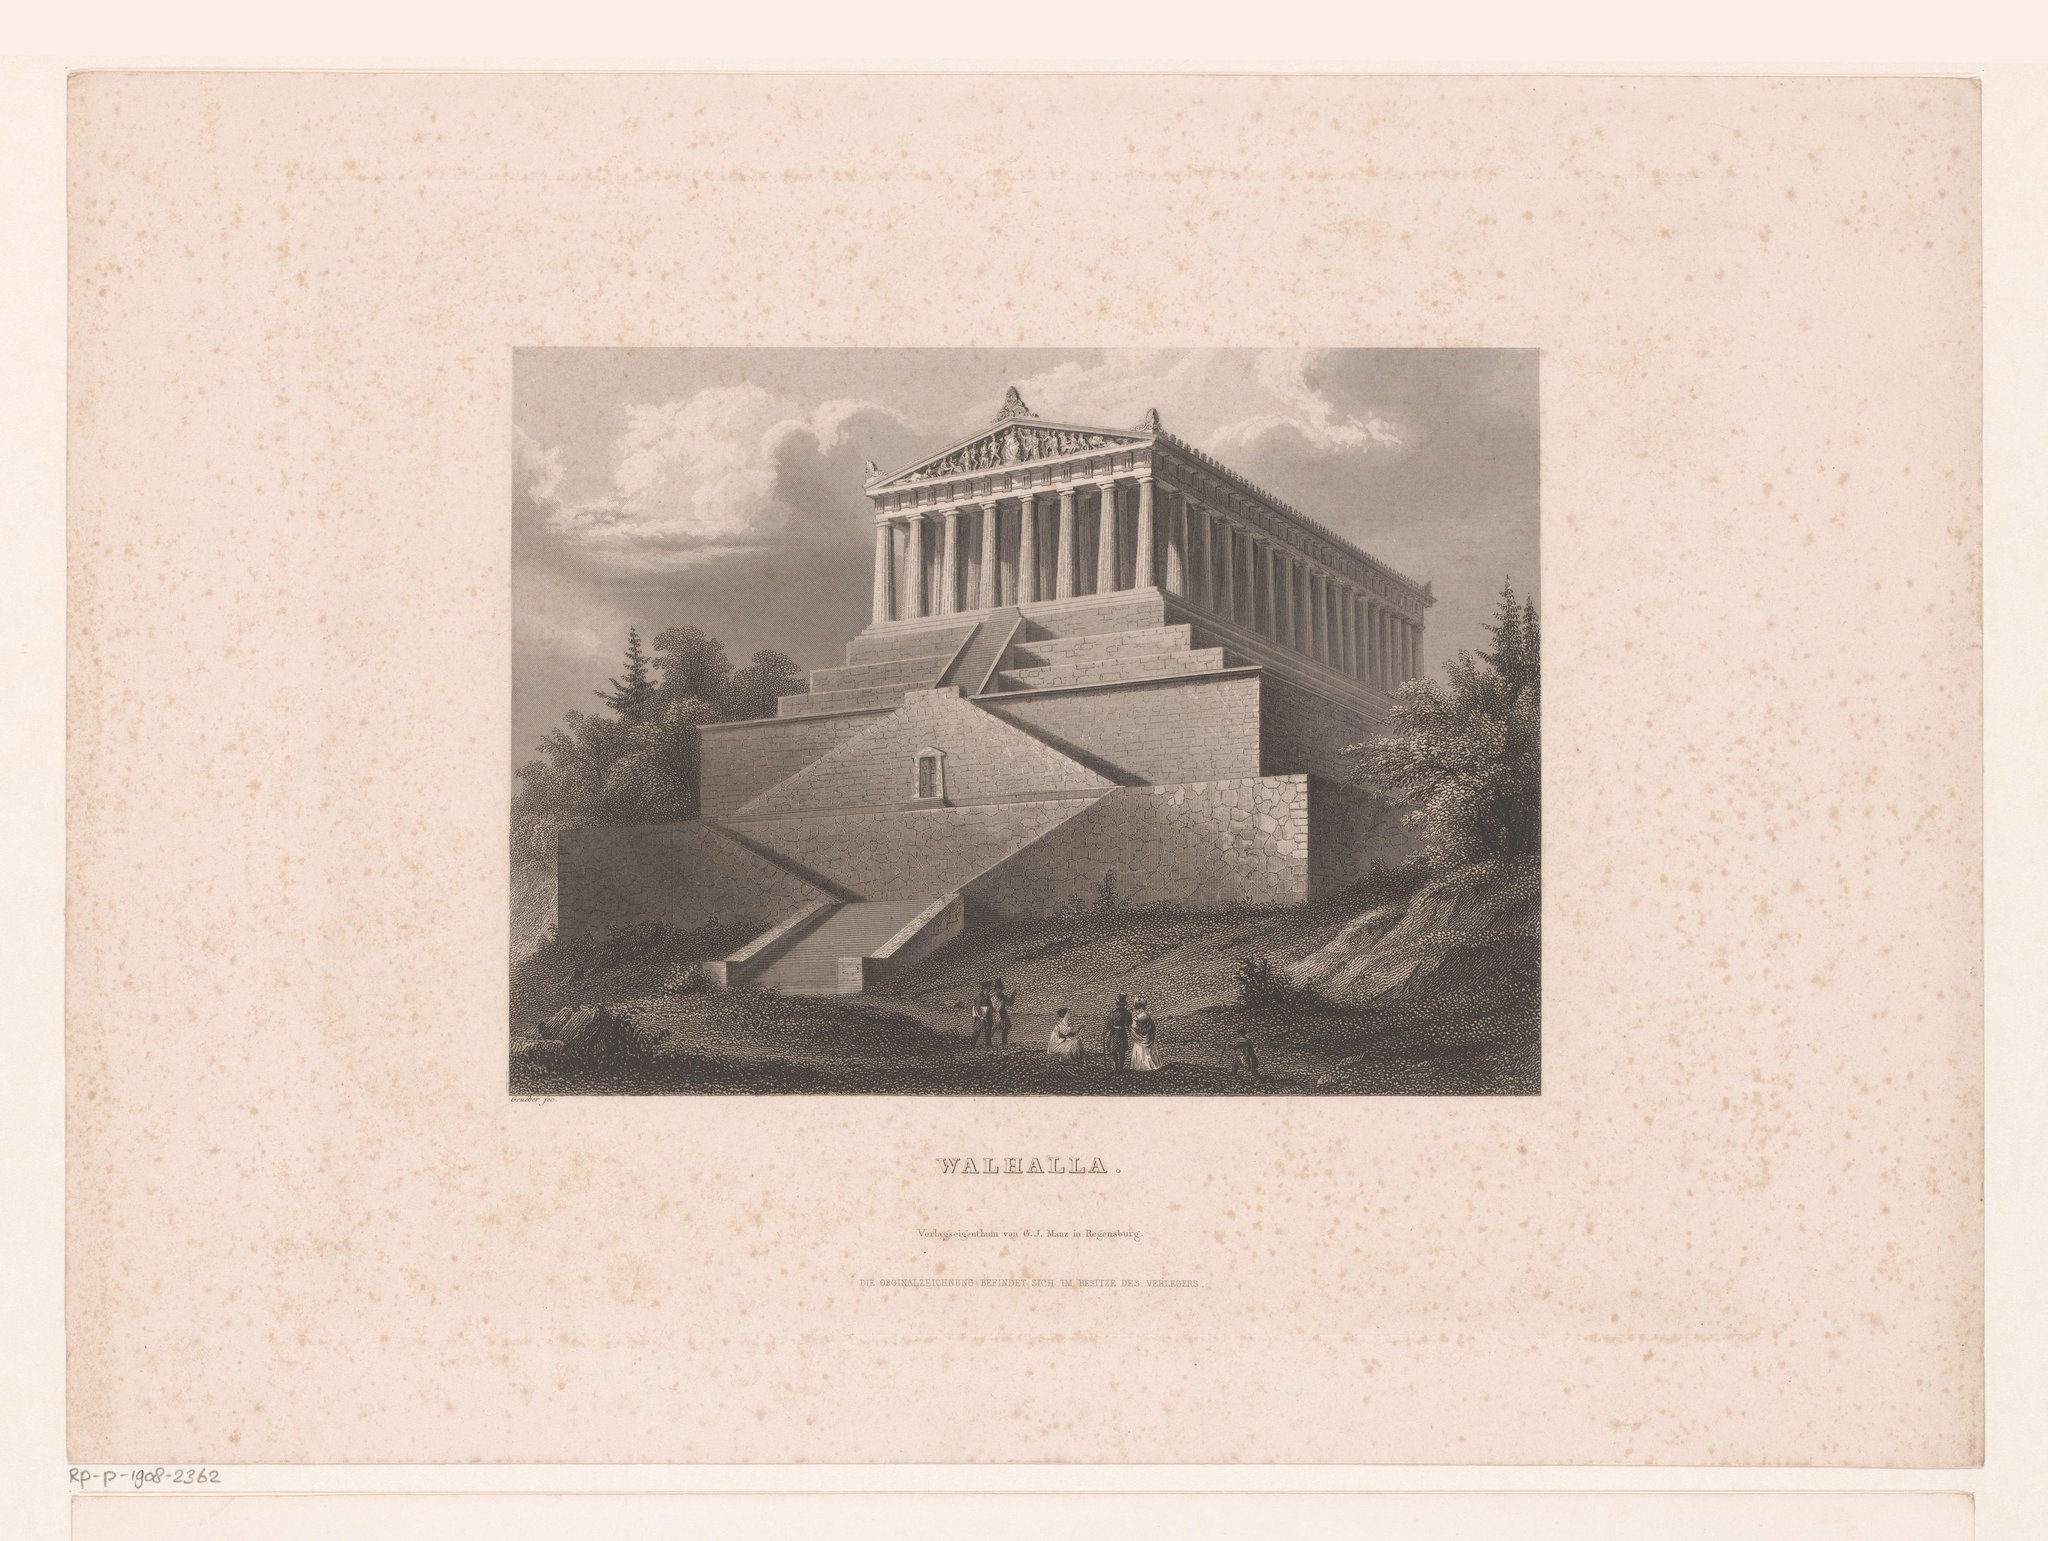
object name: print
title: Gezicht op de façade van Walhalla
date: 1816-1882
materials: paper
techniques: engraving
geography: regensburg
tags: other memorial structures, ideal and visionary architecture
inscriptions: collector's mark: Lugt 2228